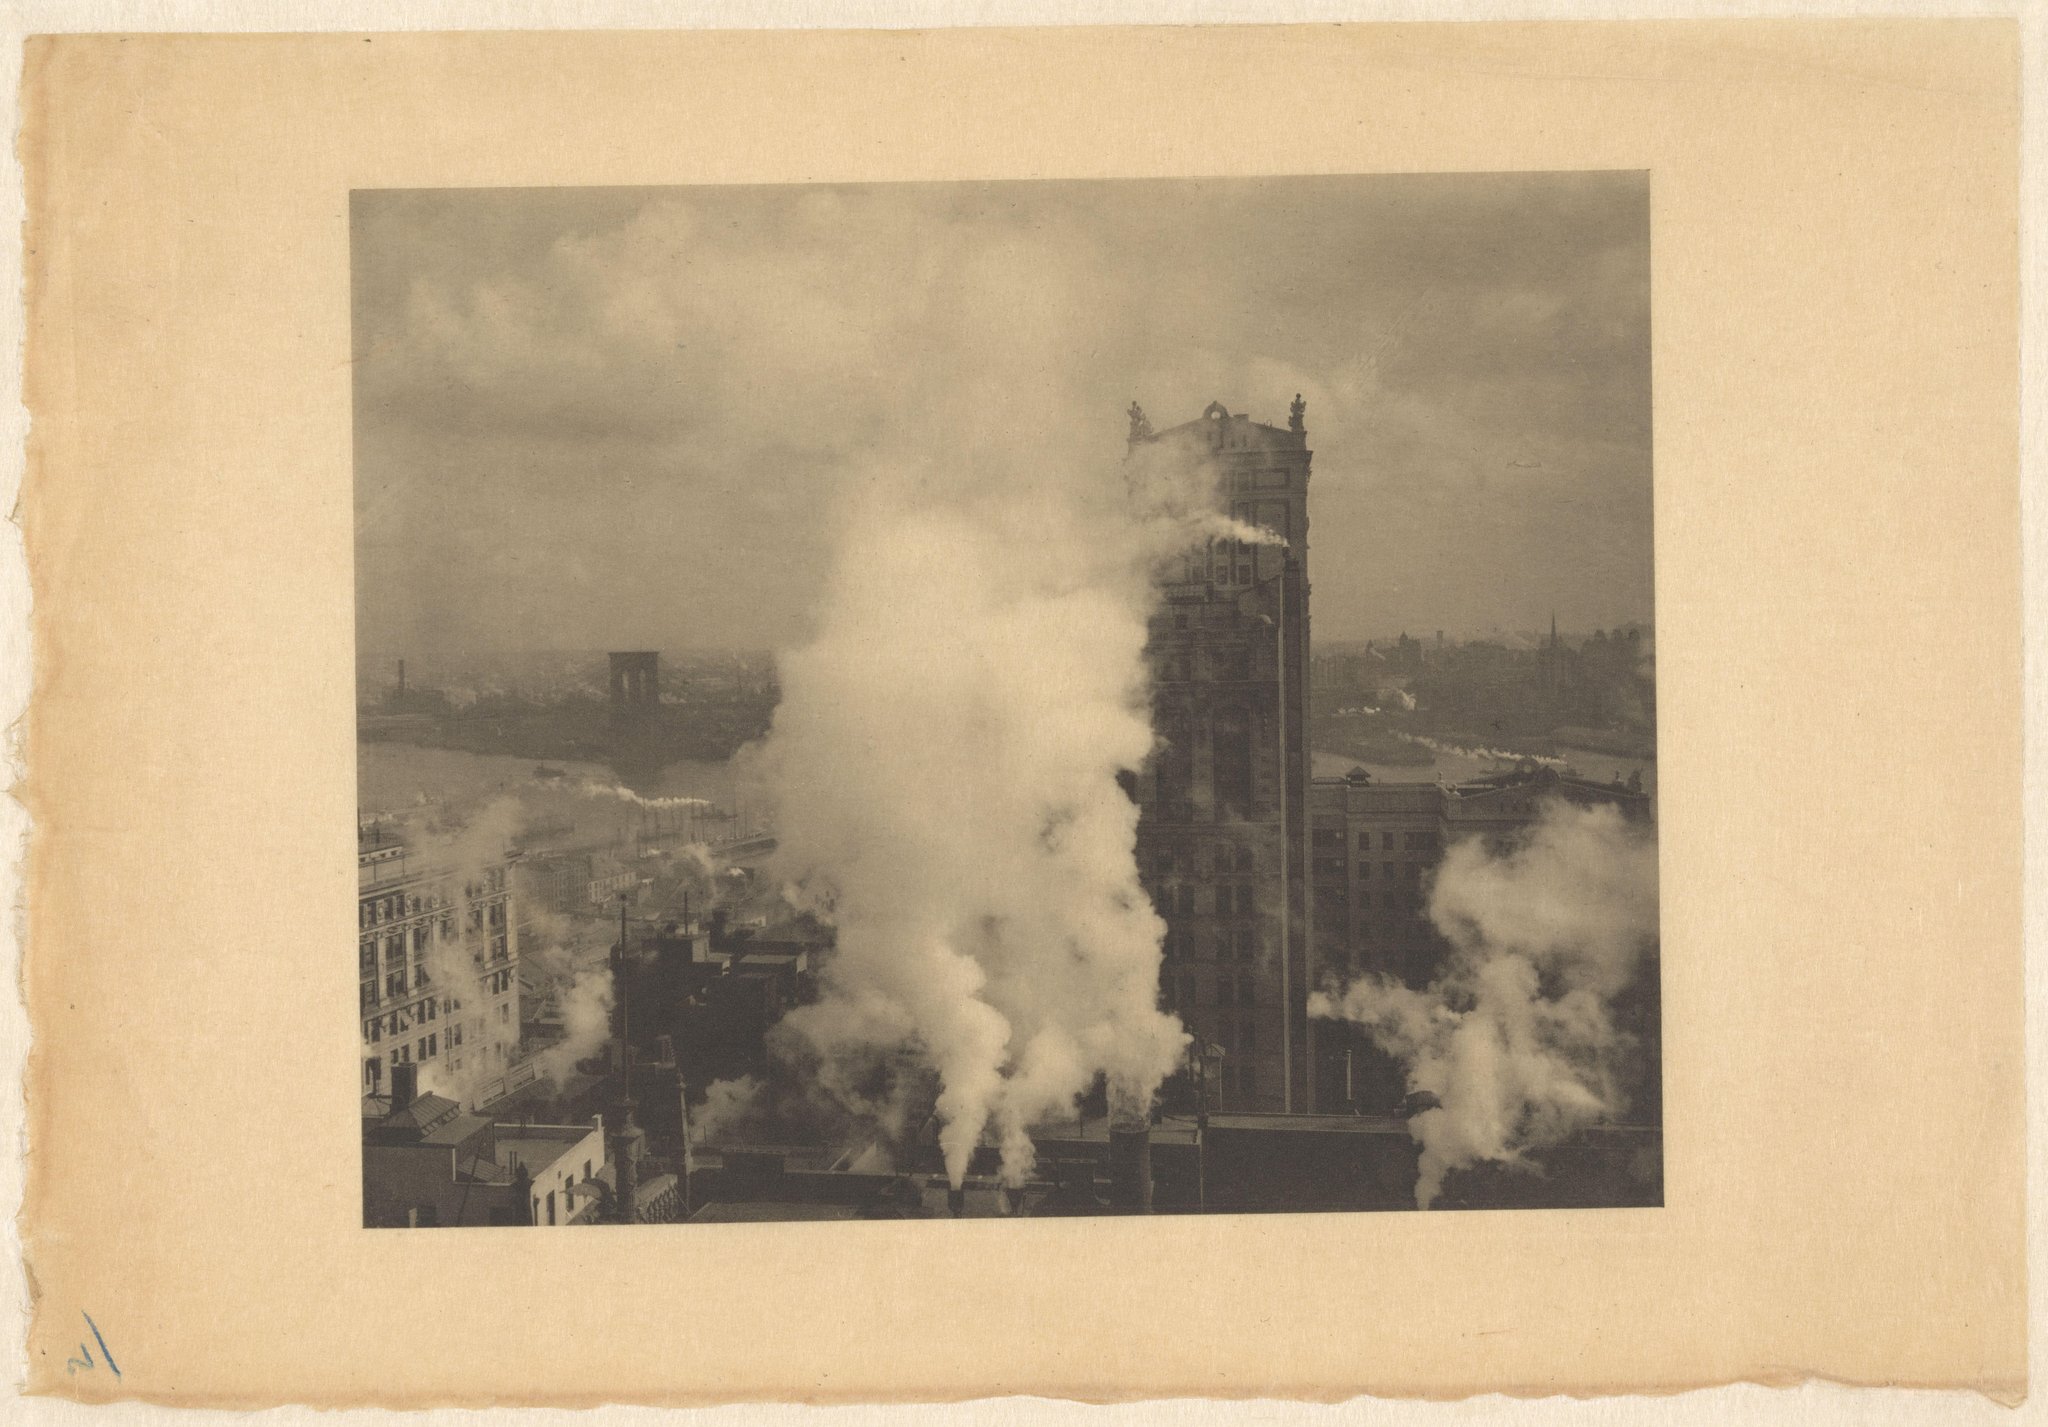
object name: photomechanical print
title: Over the House-Tops, New York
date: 1908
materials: paper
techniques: photoaquatint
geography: new york city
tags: skyscraper, steam, new york (city)